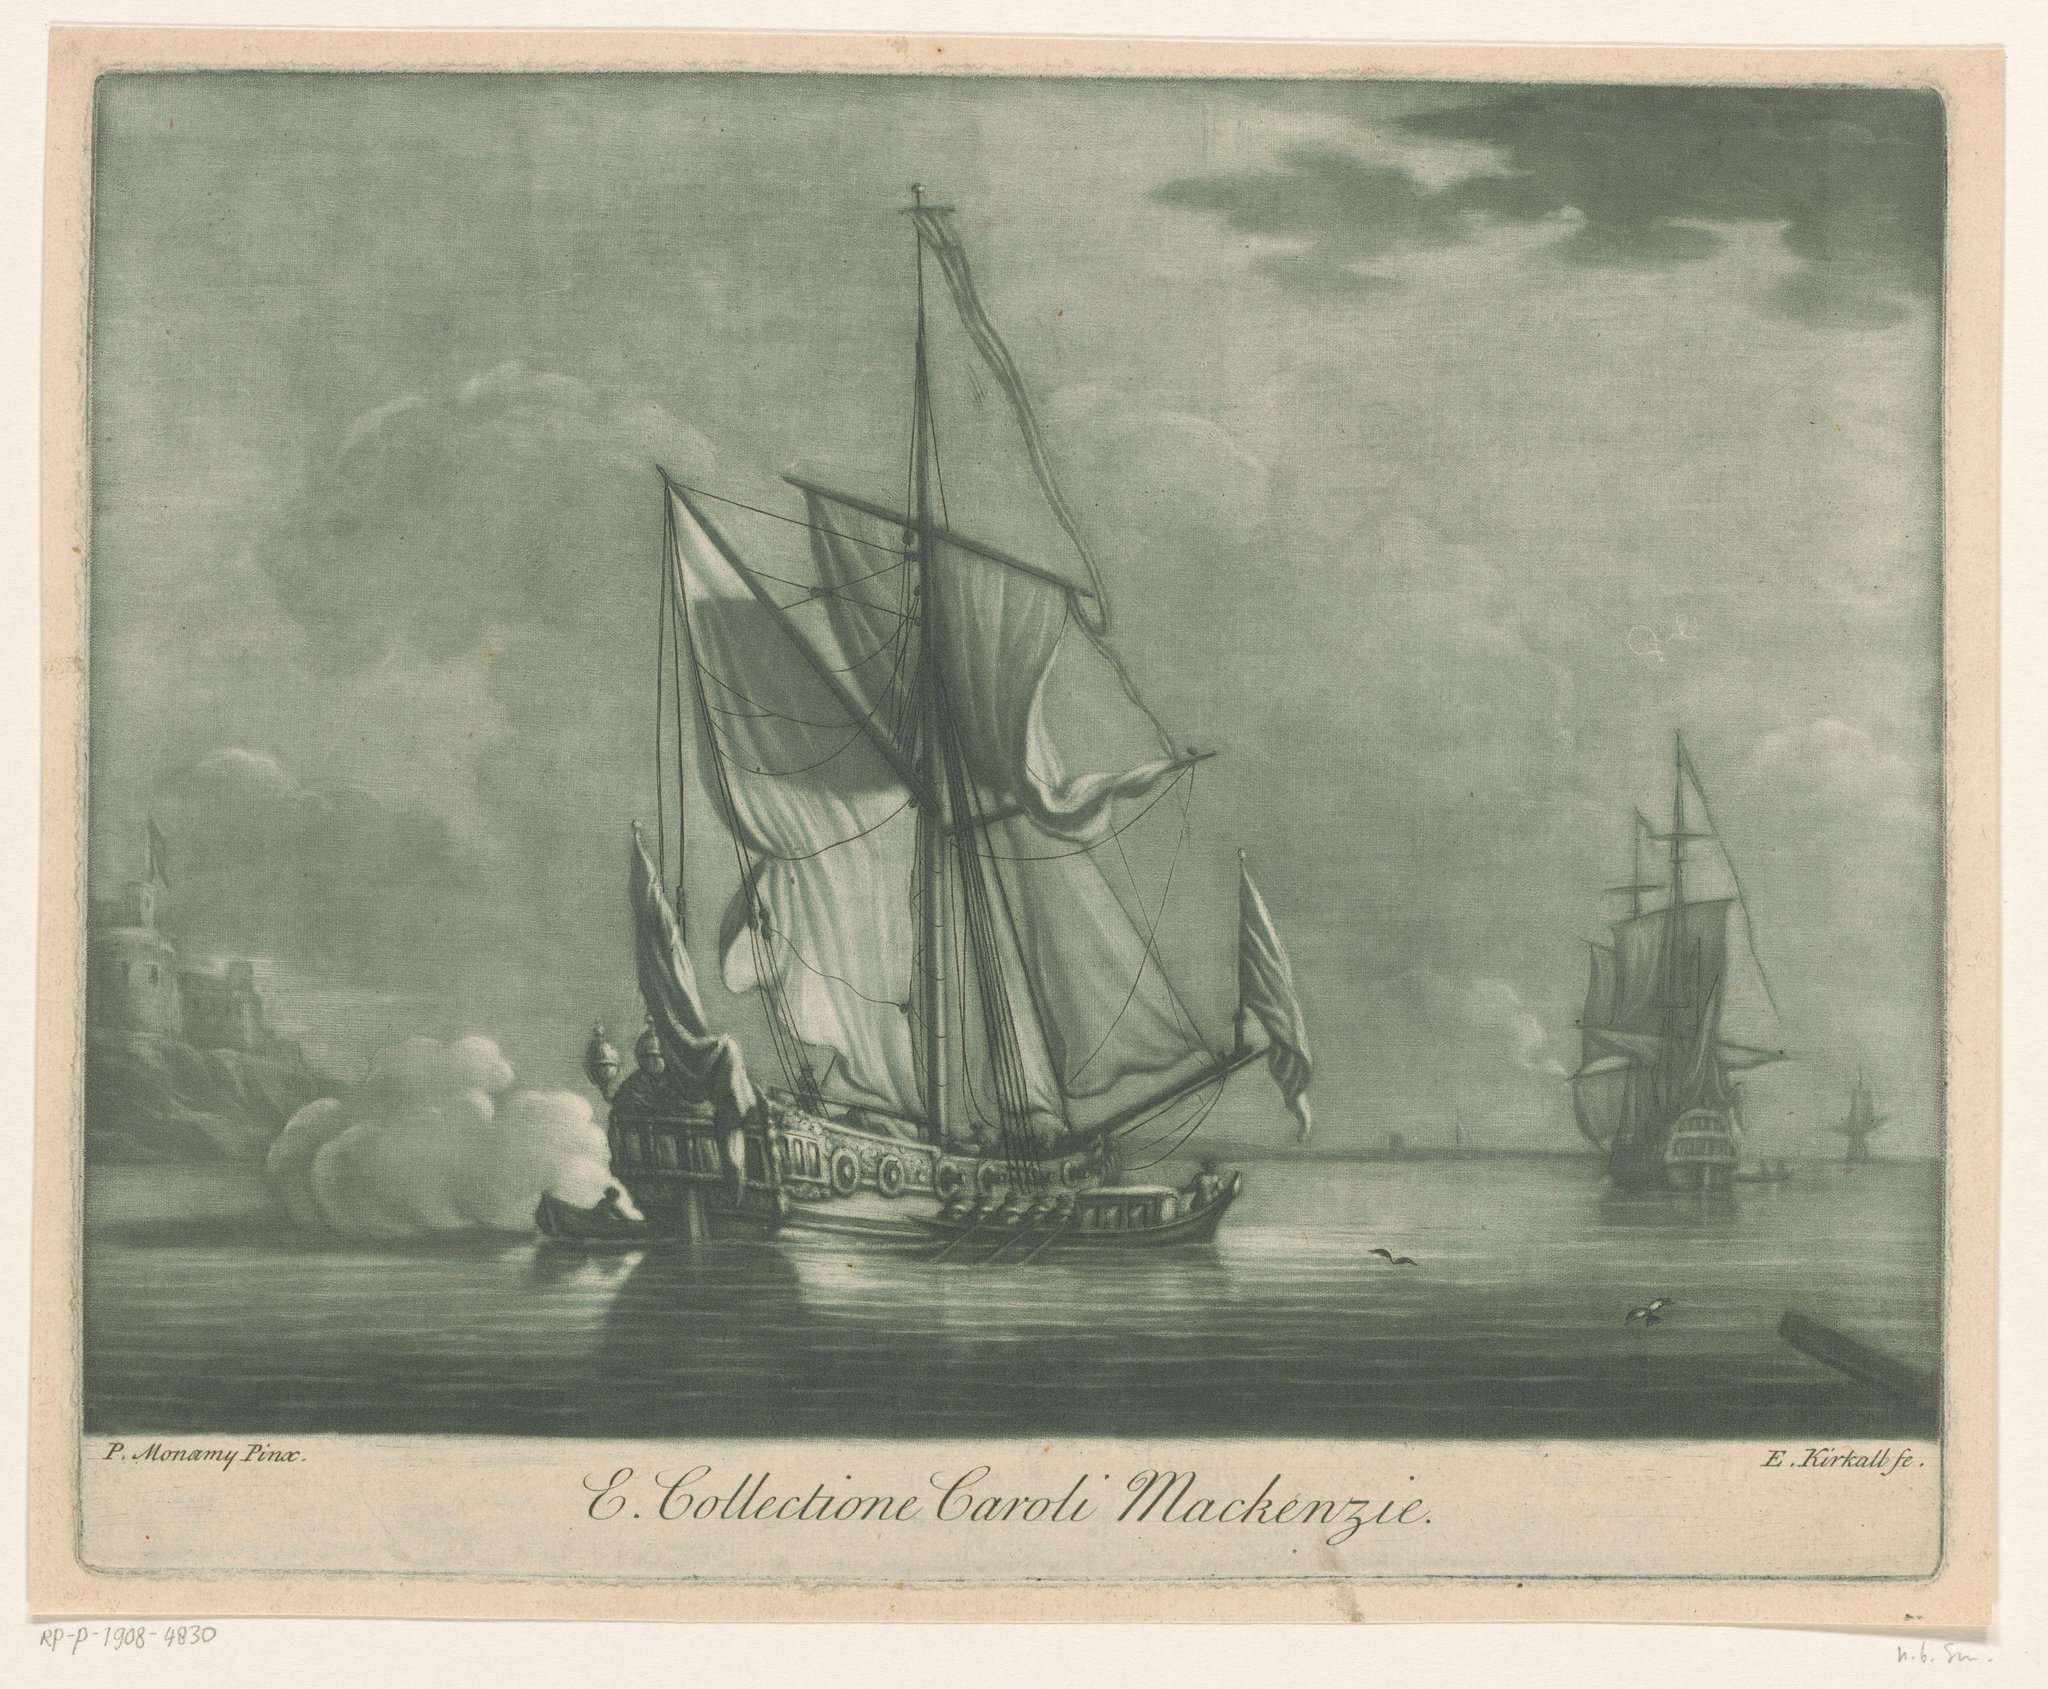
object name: print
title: Vlaggenschip vuurt een saluut voor het vertrek van de ankerplaats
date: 1692-1742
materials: paper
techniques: color etching, mezzotint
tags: navy, departure ~ travelling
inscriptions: collector's mark: Lugt 2228